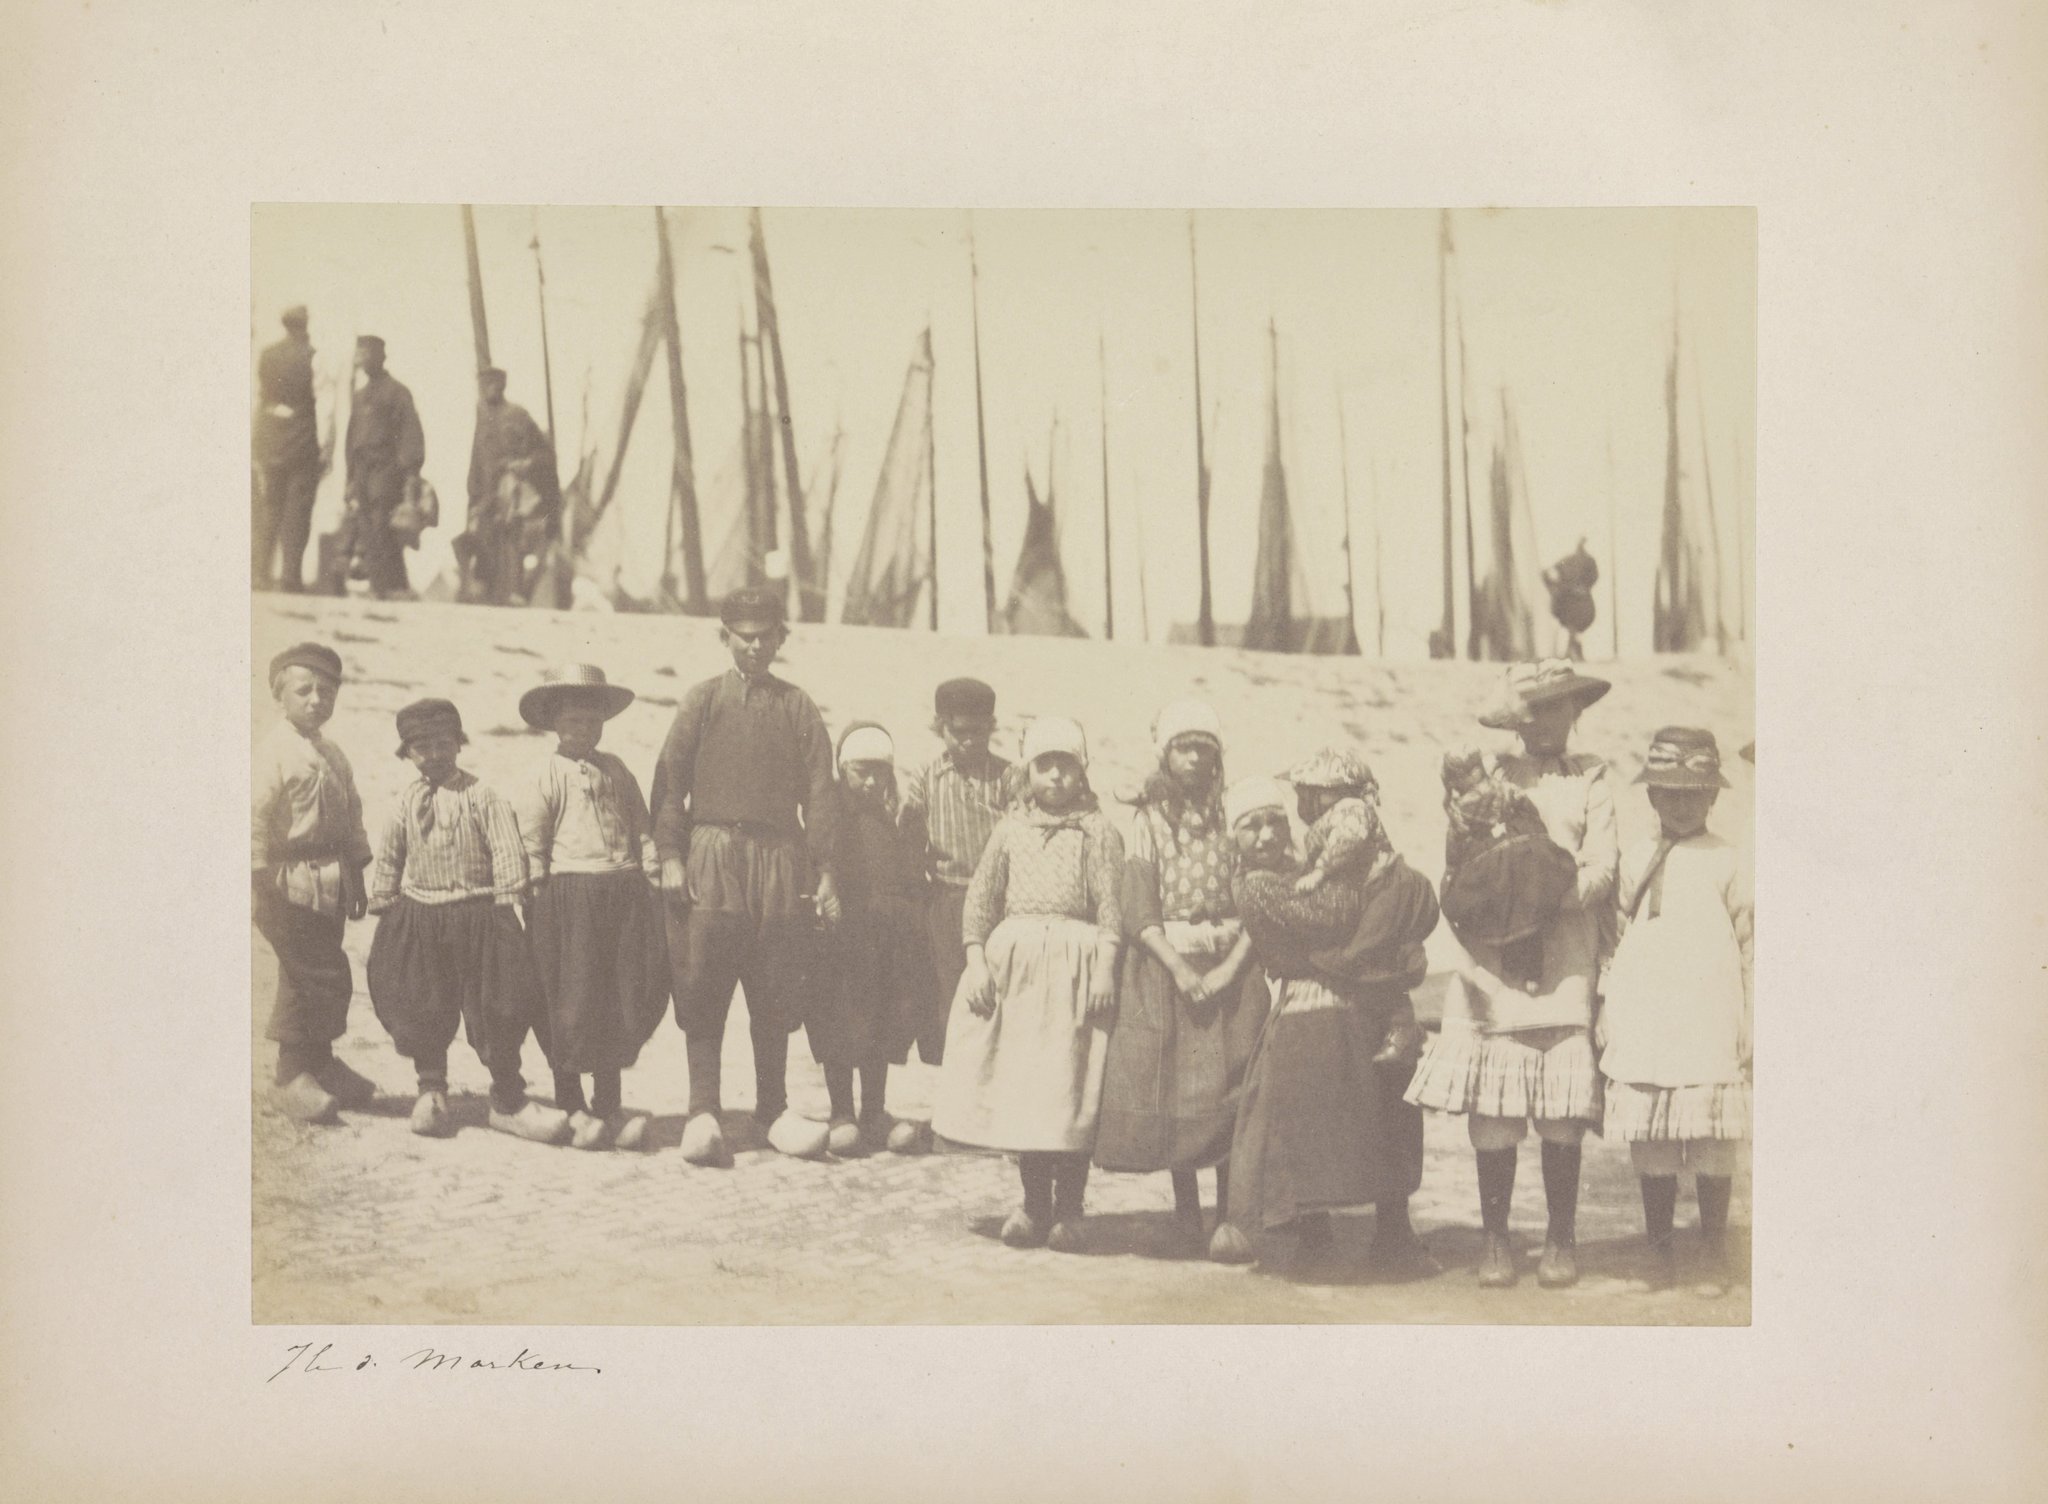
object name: photograph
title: Kinderen in klederdracht op het eiland Marken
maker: Anonymous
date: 1885-1900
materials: paper, photographic support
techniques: albumen print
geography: france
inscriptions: annotation: ‘Ile de Marken’